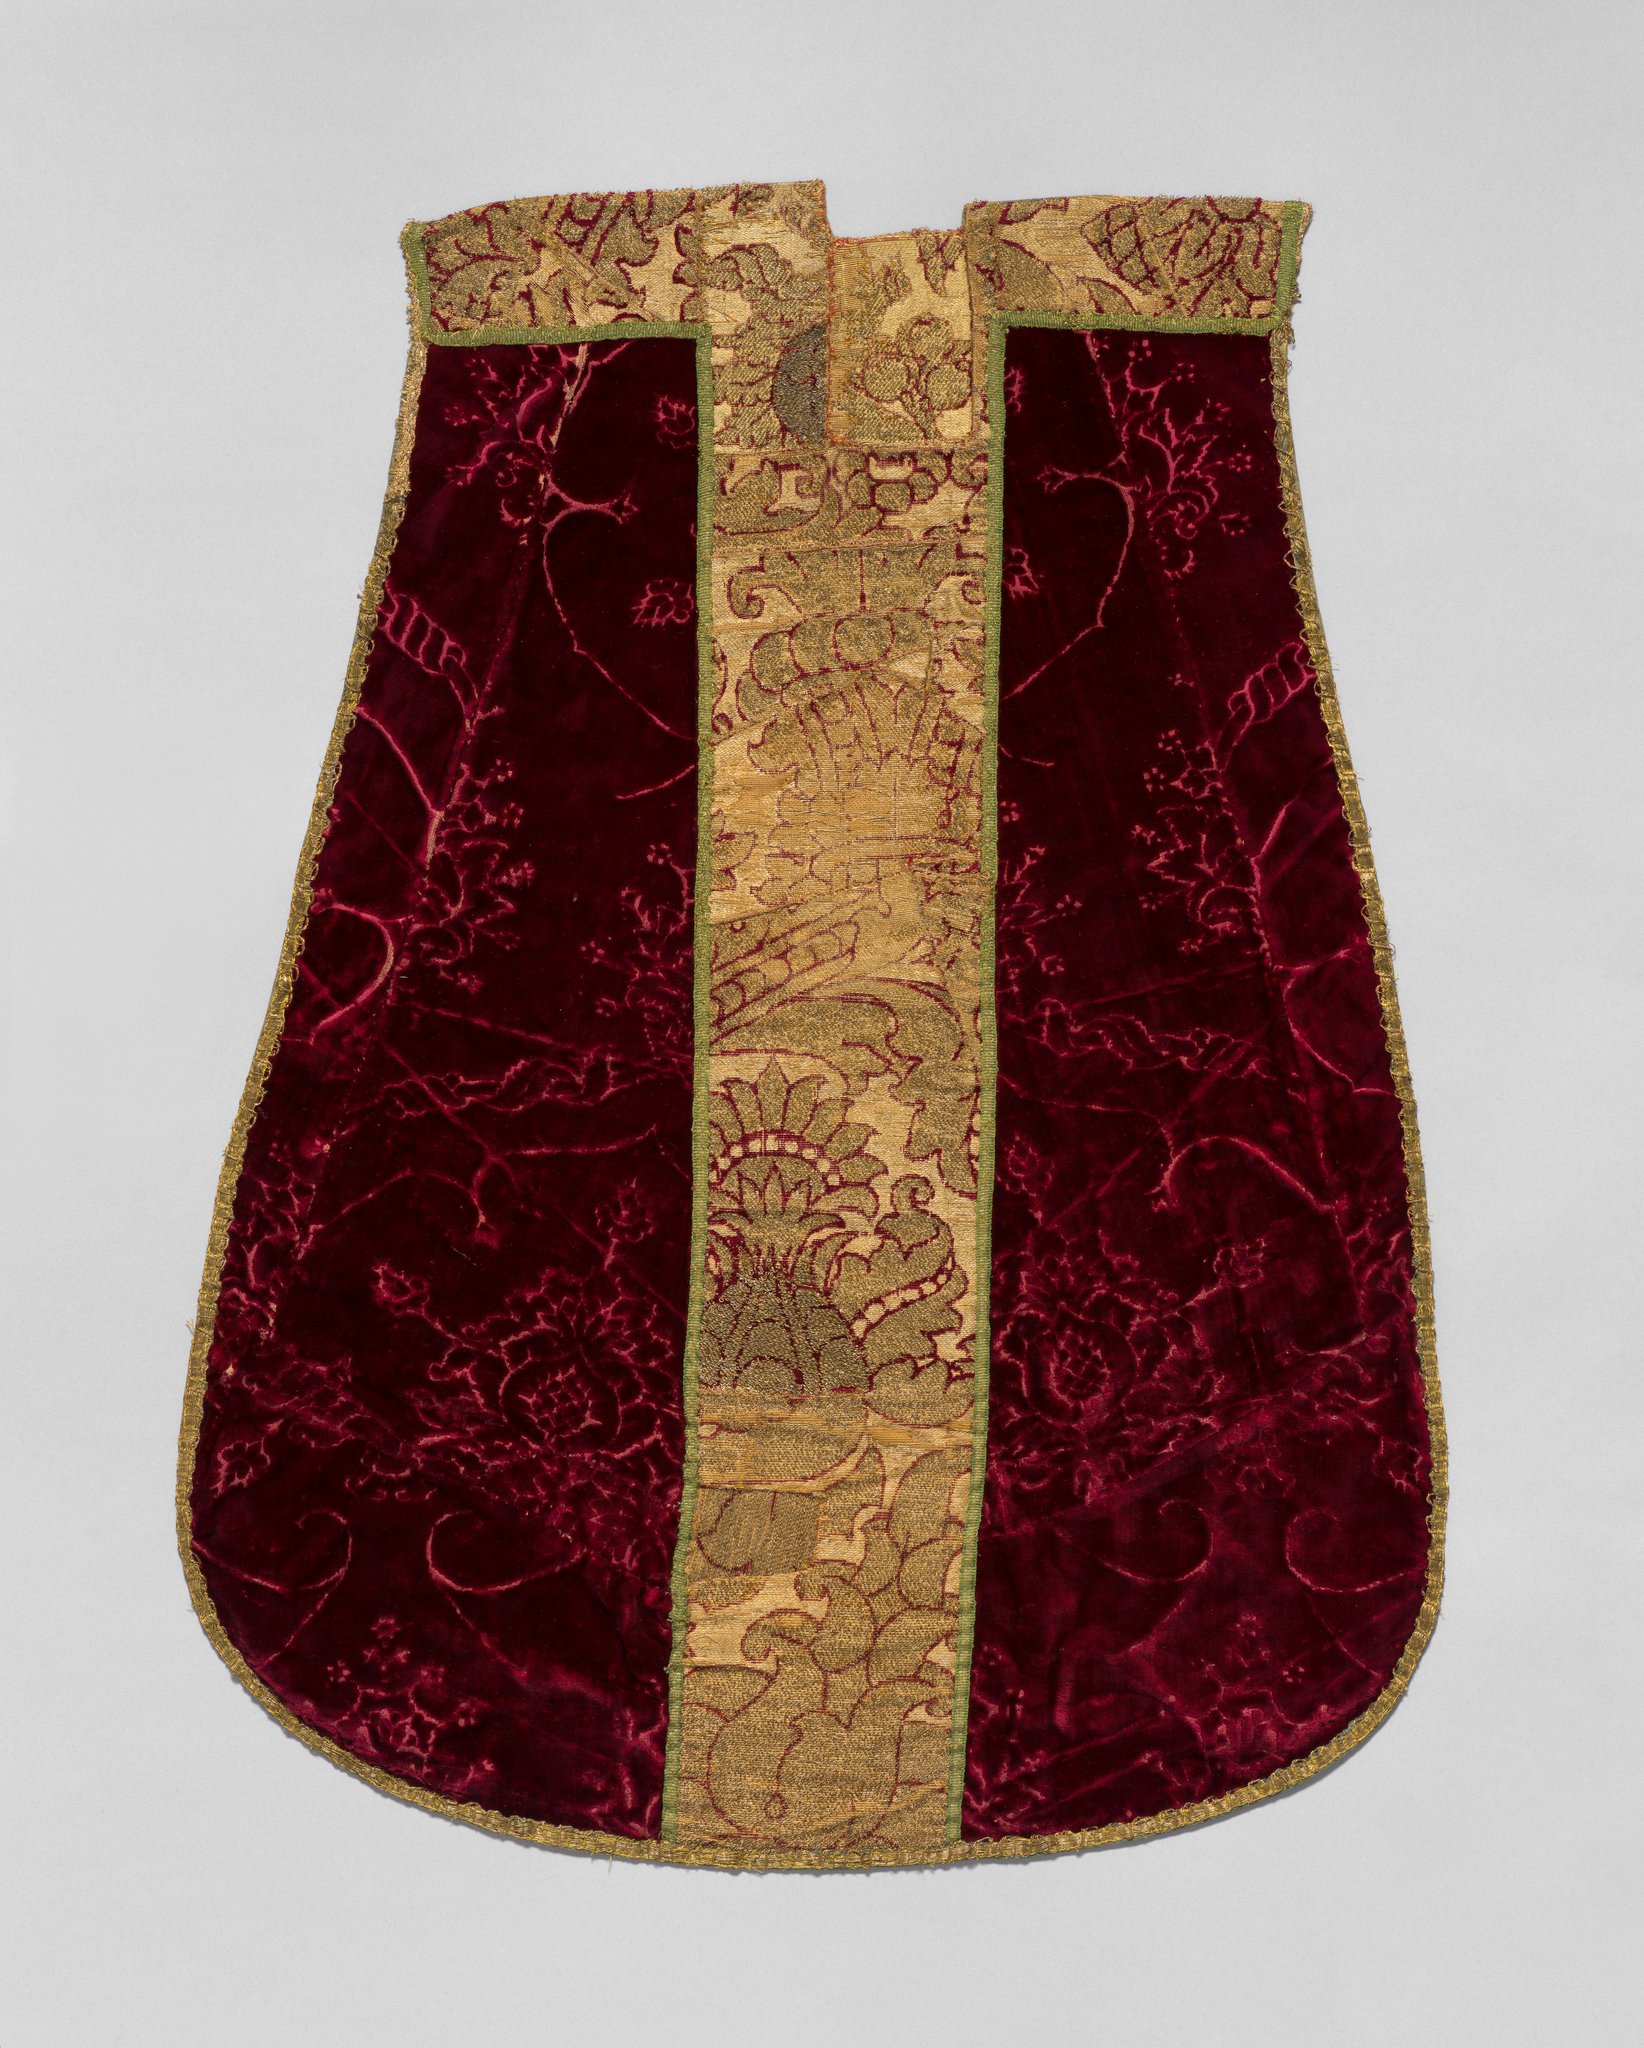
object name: chasuble fragment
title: Chasuble front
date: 1501-1533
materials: metal thread, silk